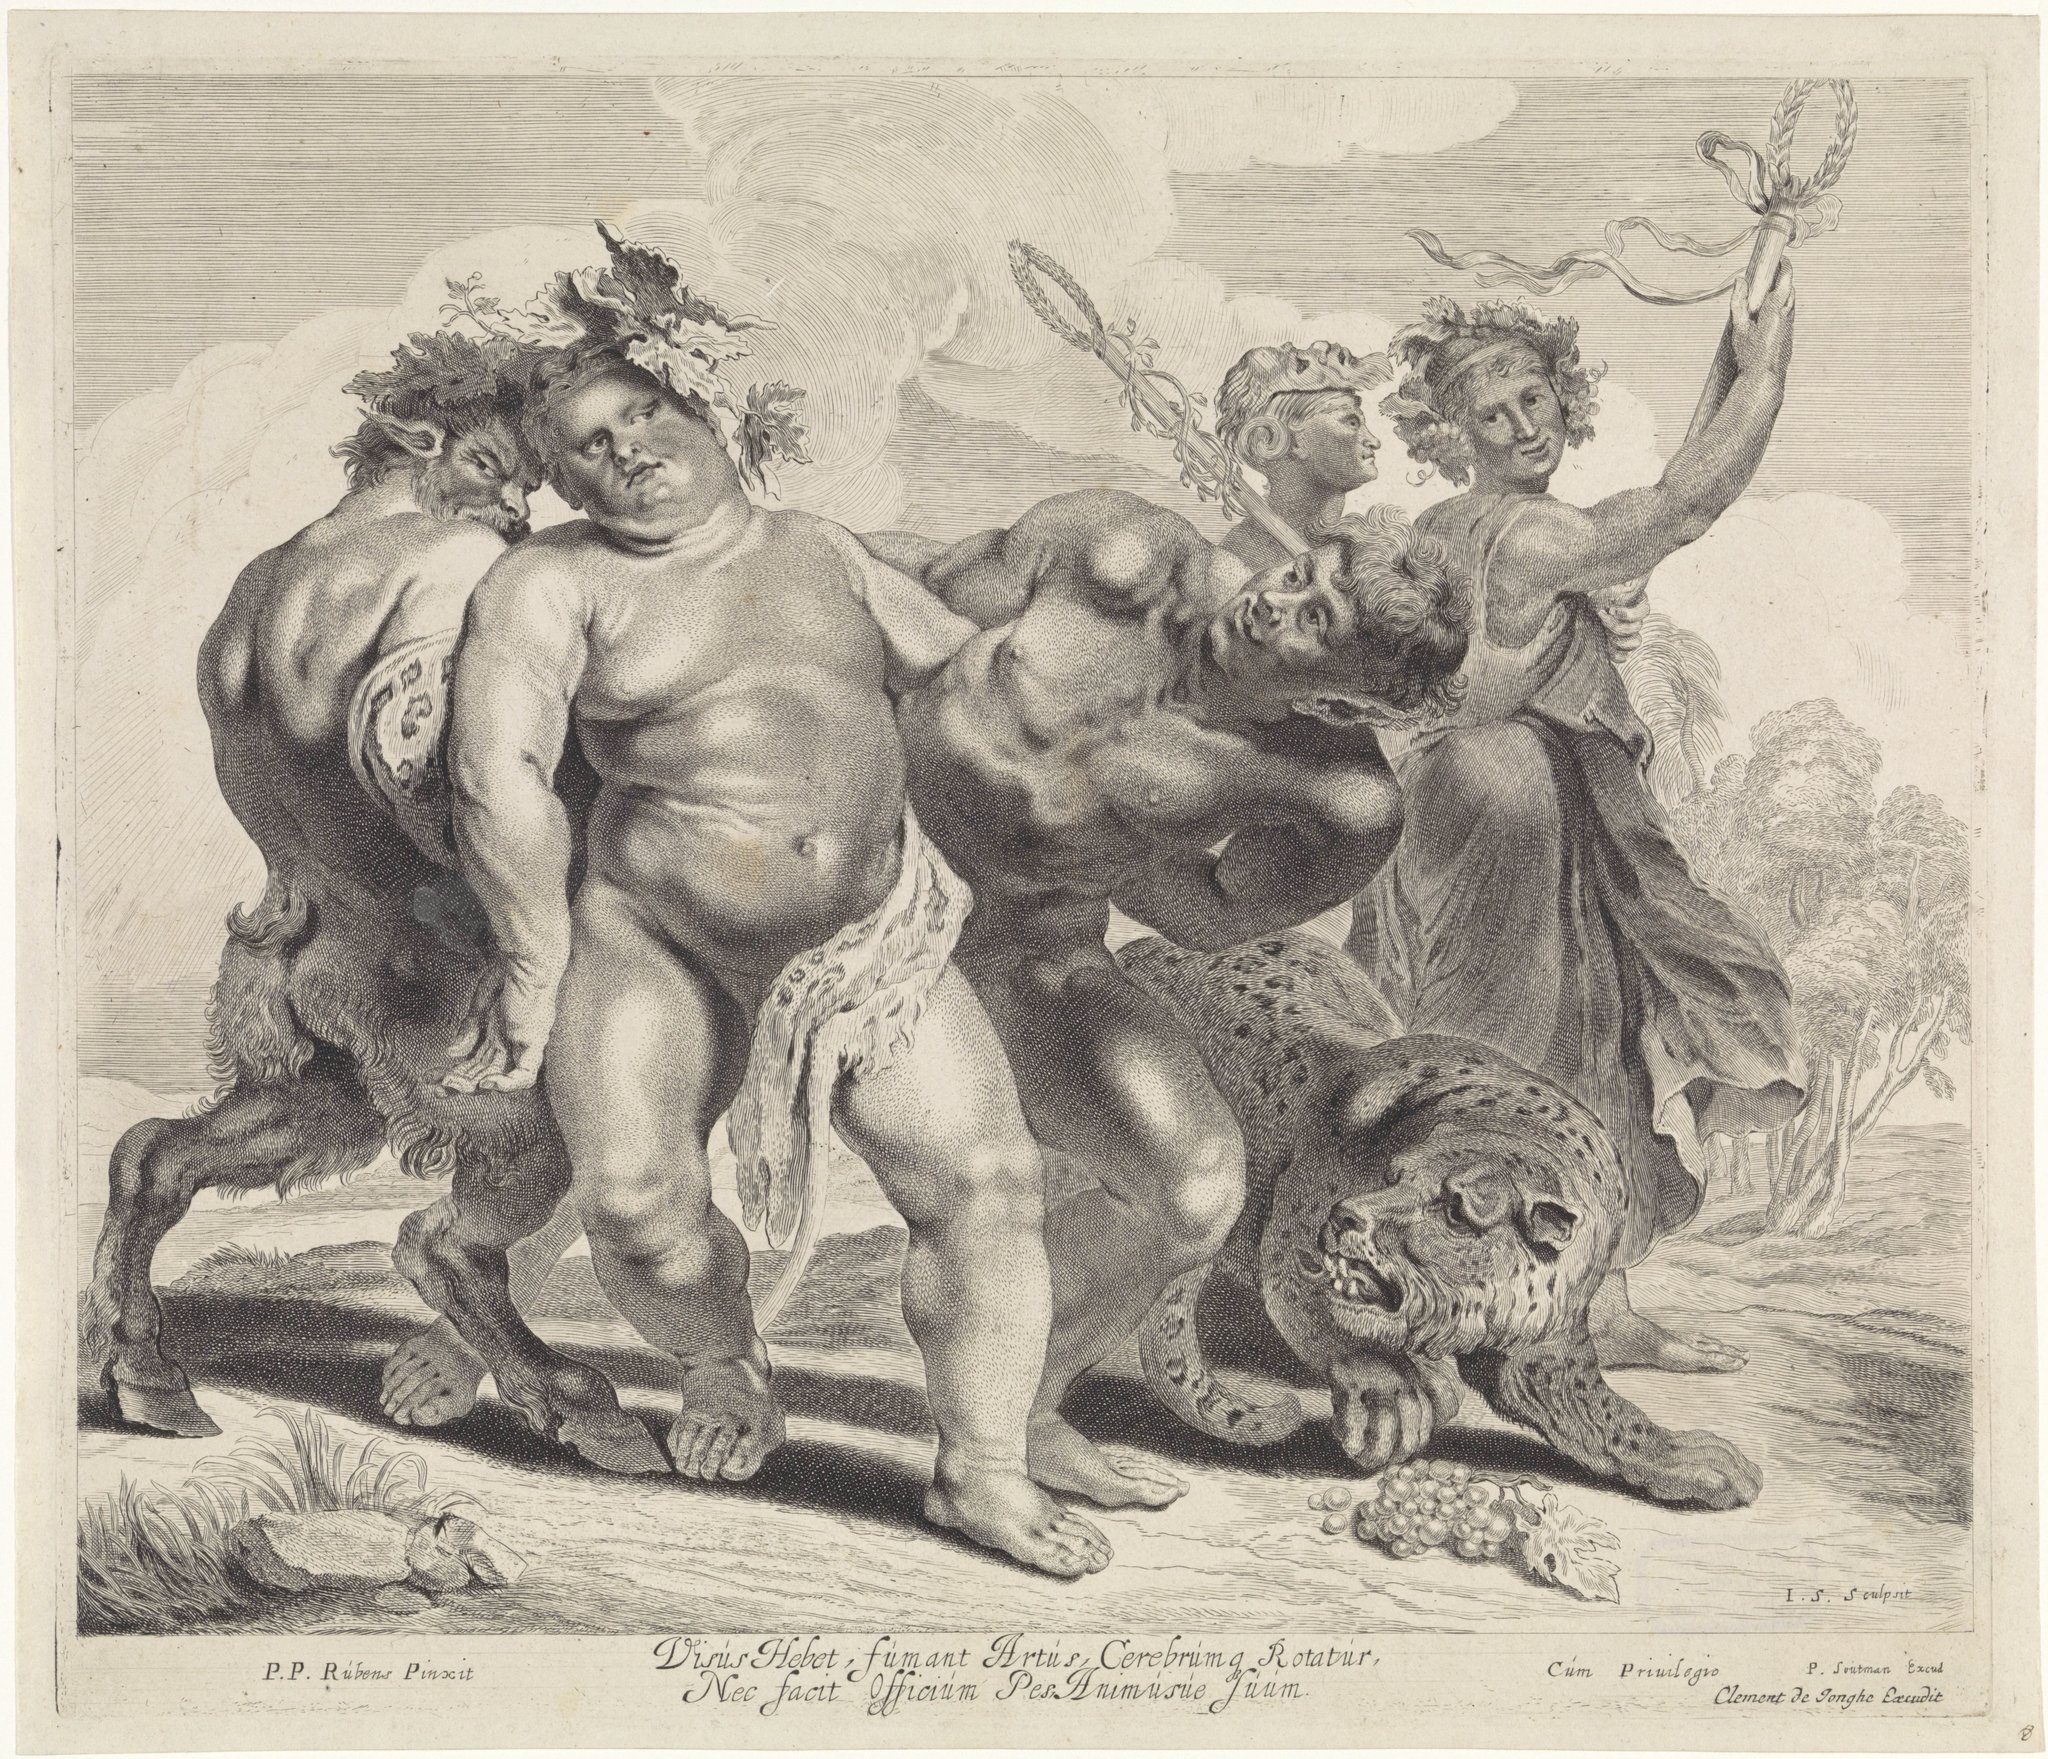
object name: print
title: Dronkenschap van Bacchus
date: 1643-1677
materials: paper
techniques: engraving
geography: haarlem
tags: satyr(s) (in general), the drunken bacchus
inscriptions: collector's mark: Lugt 11, collector's mark: Lugt 10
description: De dronken Bacchus wordt ondersteund door twee saters. Hij is slechts gekleed in een tijgervel. Rechts een luipaard en maenaden.